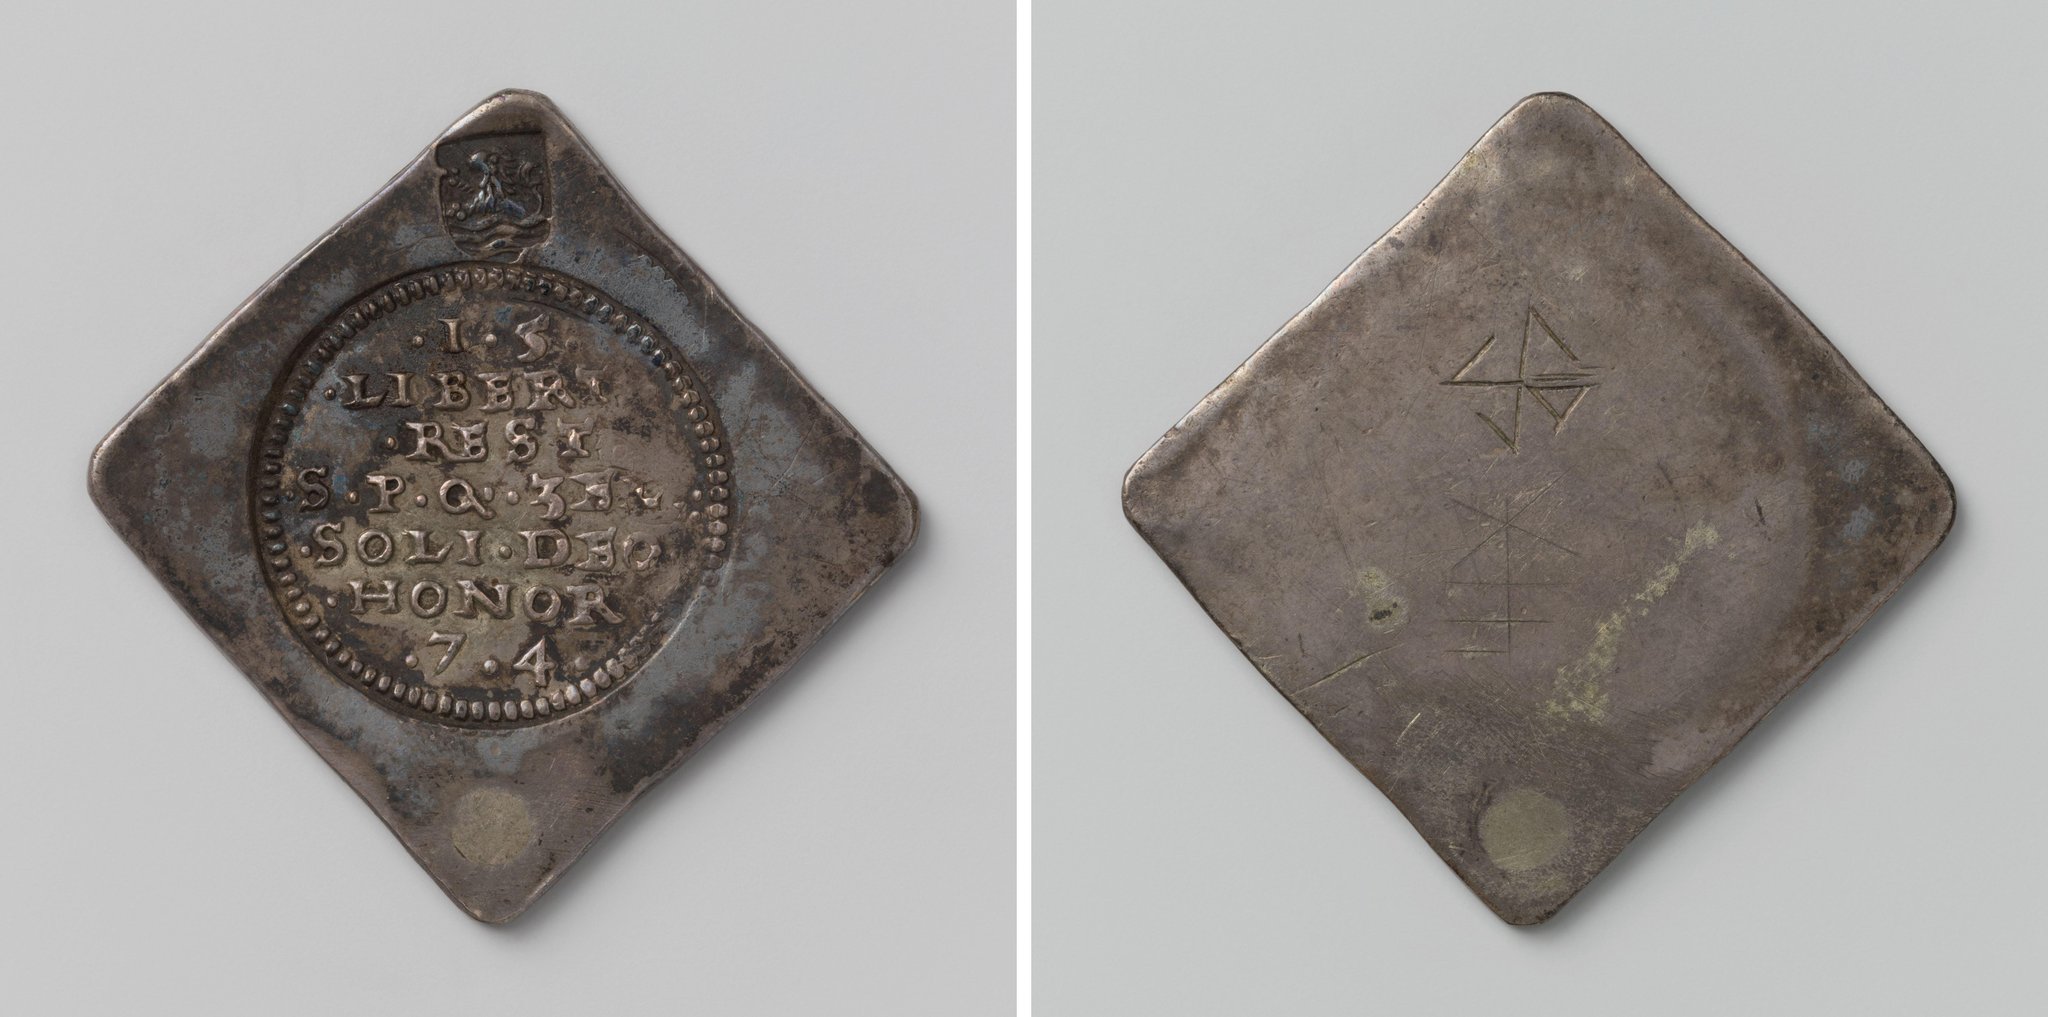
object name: siege coin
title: Halve daalder, noodmunt uit Middelburg, geslagen na het beleg en de inname van de stad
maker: Anonymous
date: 1503-1574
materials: silver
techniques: engraving, striking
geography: middelburg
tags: middelburg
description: ruitvormige noodmunt met afgeronde hoeken. Voorzijde: twee stempels boven elkaar: bovenste stempel: wapenschild; daaronder: opschrift in ronde parelrand. Keerzijde: huismerk